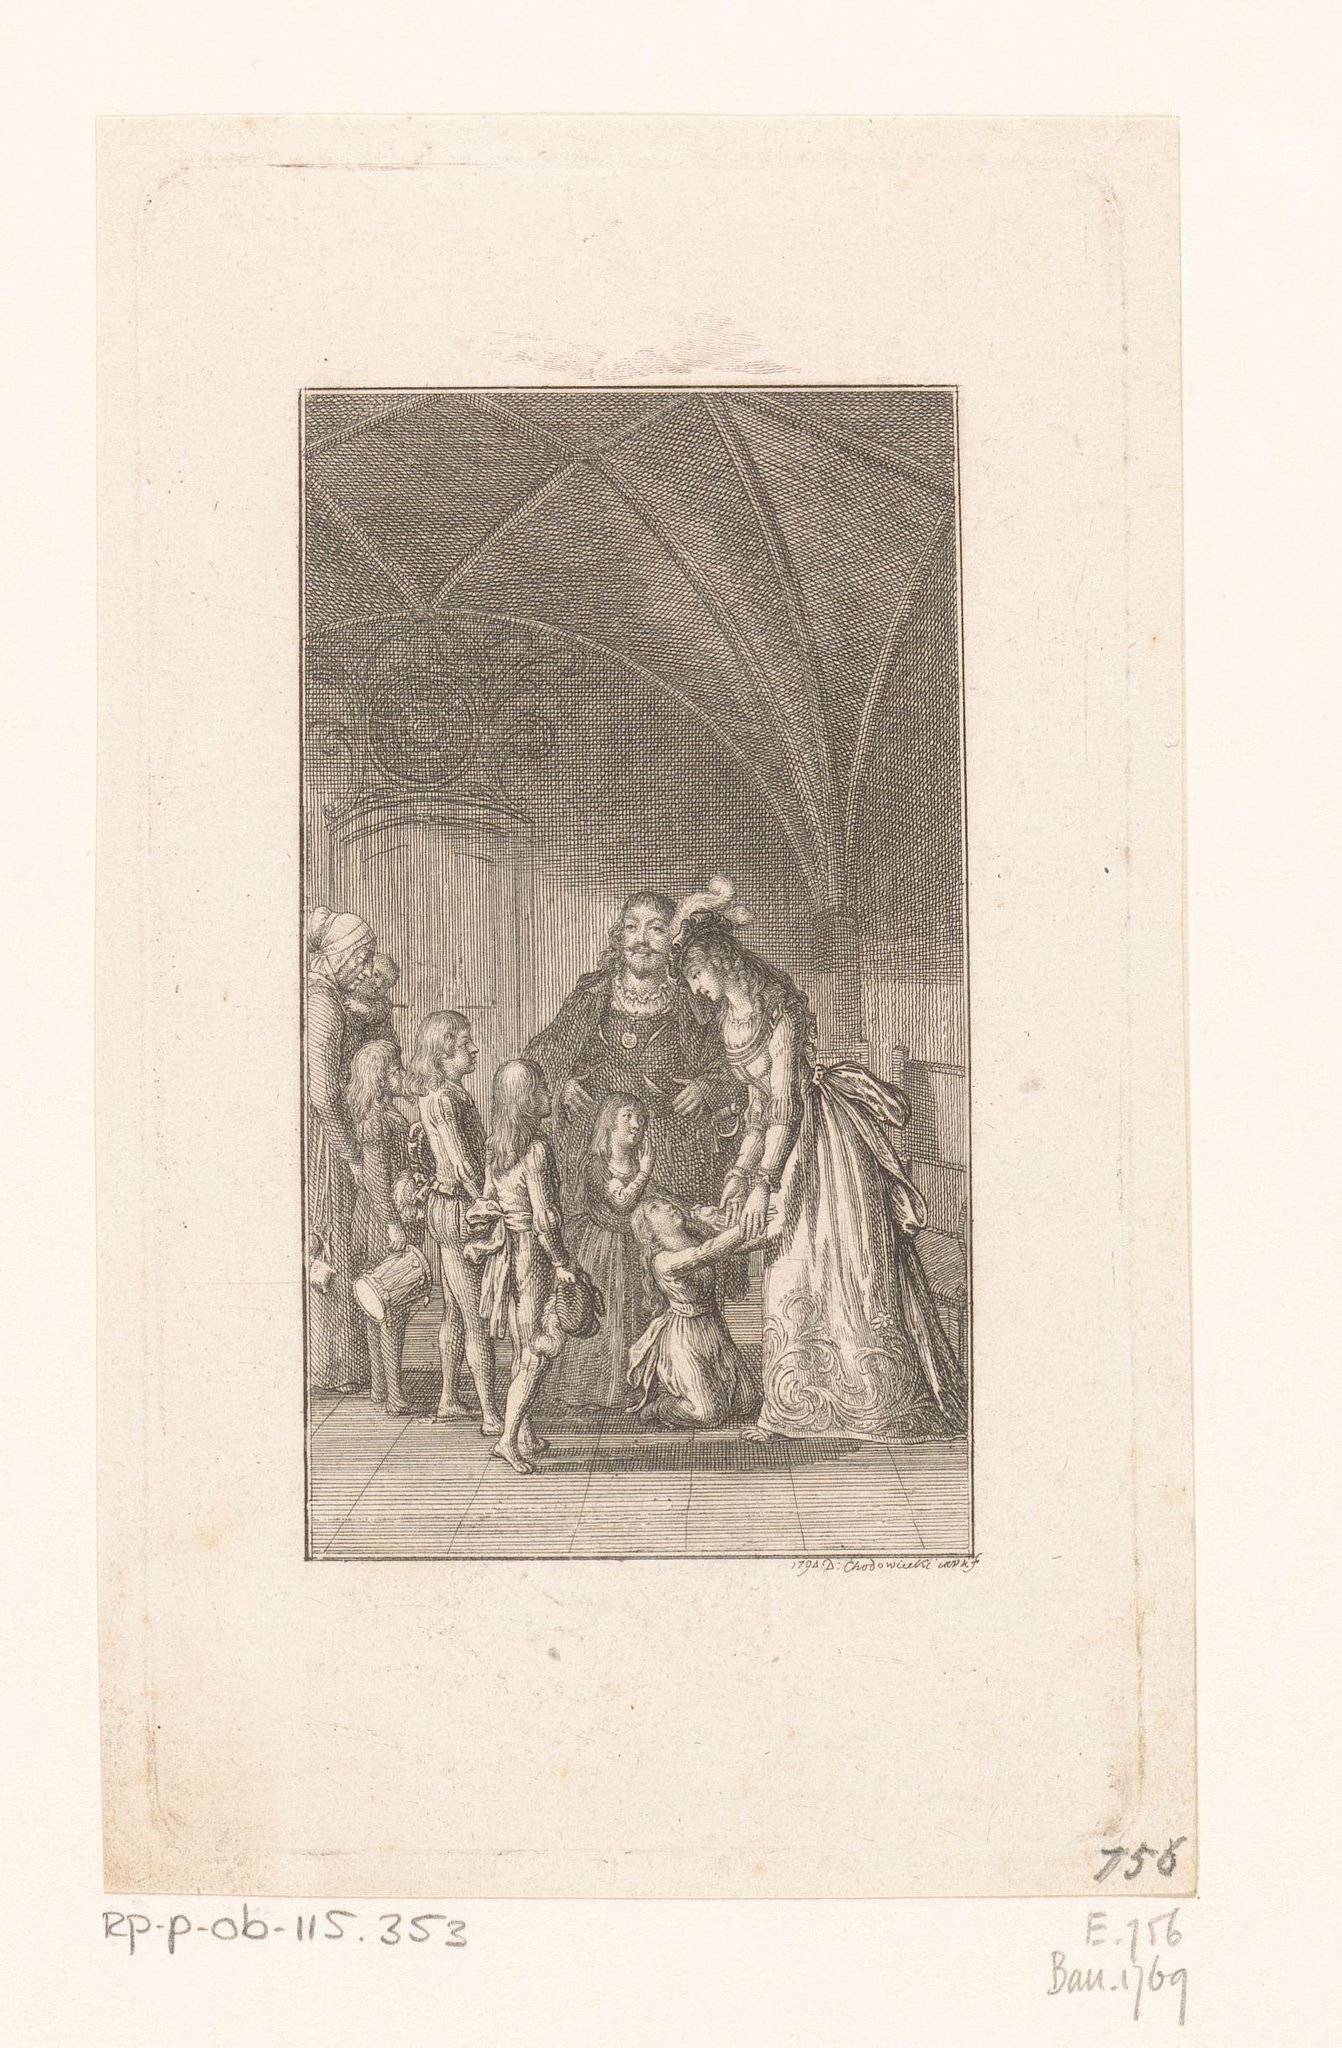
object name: print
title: Francesco stelt zijn kinderen voor aan Lucretia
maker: daniel nikolaus chodowiecki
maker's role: draughtsman, print maker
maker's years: 1726-1801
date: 1794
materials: paper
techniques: etching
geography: berlin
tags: stepmother, vault ~ architecture, father and child(ren), man and child(ren) (family group)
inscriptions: collector's mark: Lugt 2228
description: Vervaardigd voor Wilhelm Gottlieb Beckers 'Beatrice Cenci, eine römische Geschichte'. Latere staat gebruikt voor: Leipziger Monatschrift für Damen für 1795 (...). Leipzig: Voss und Companie, [1794].